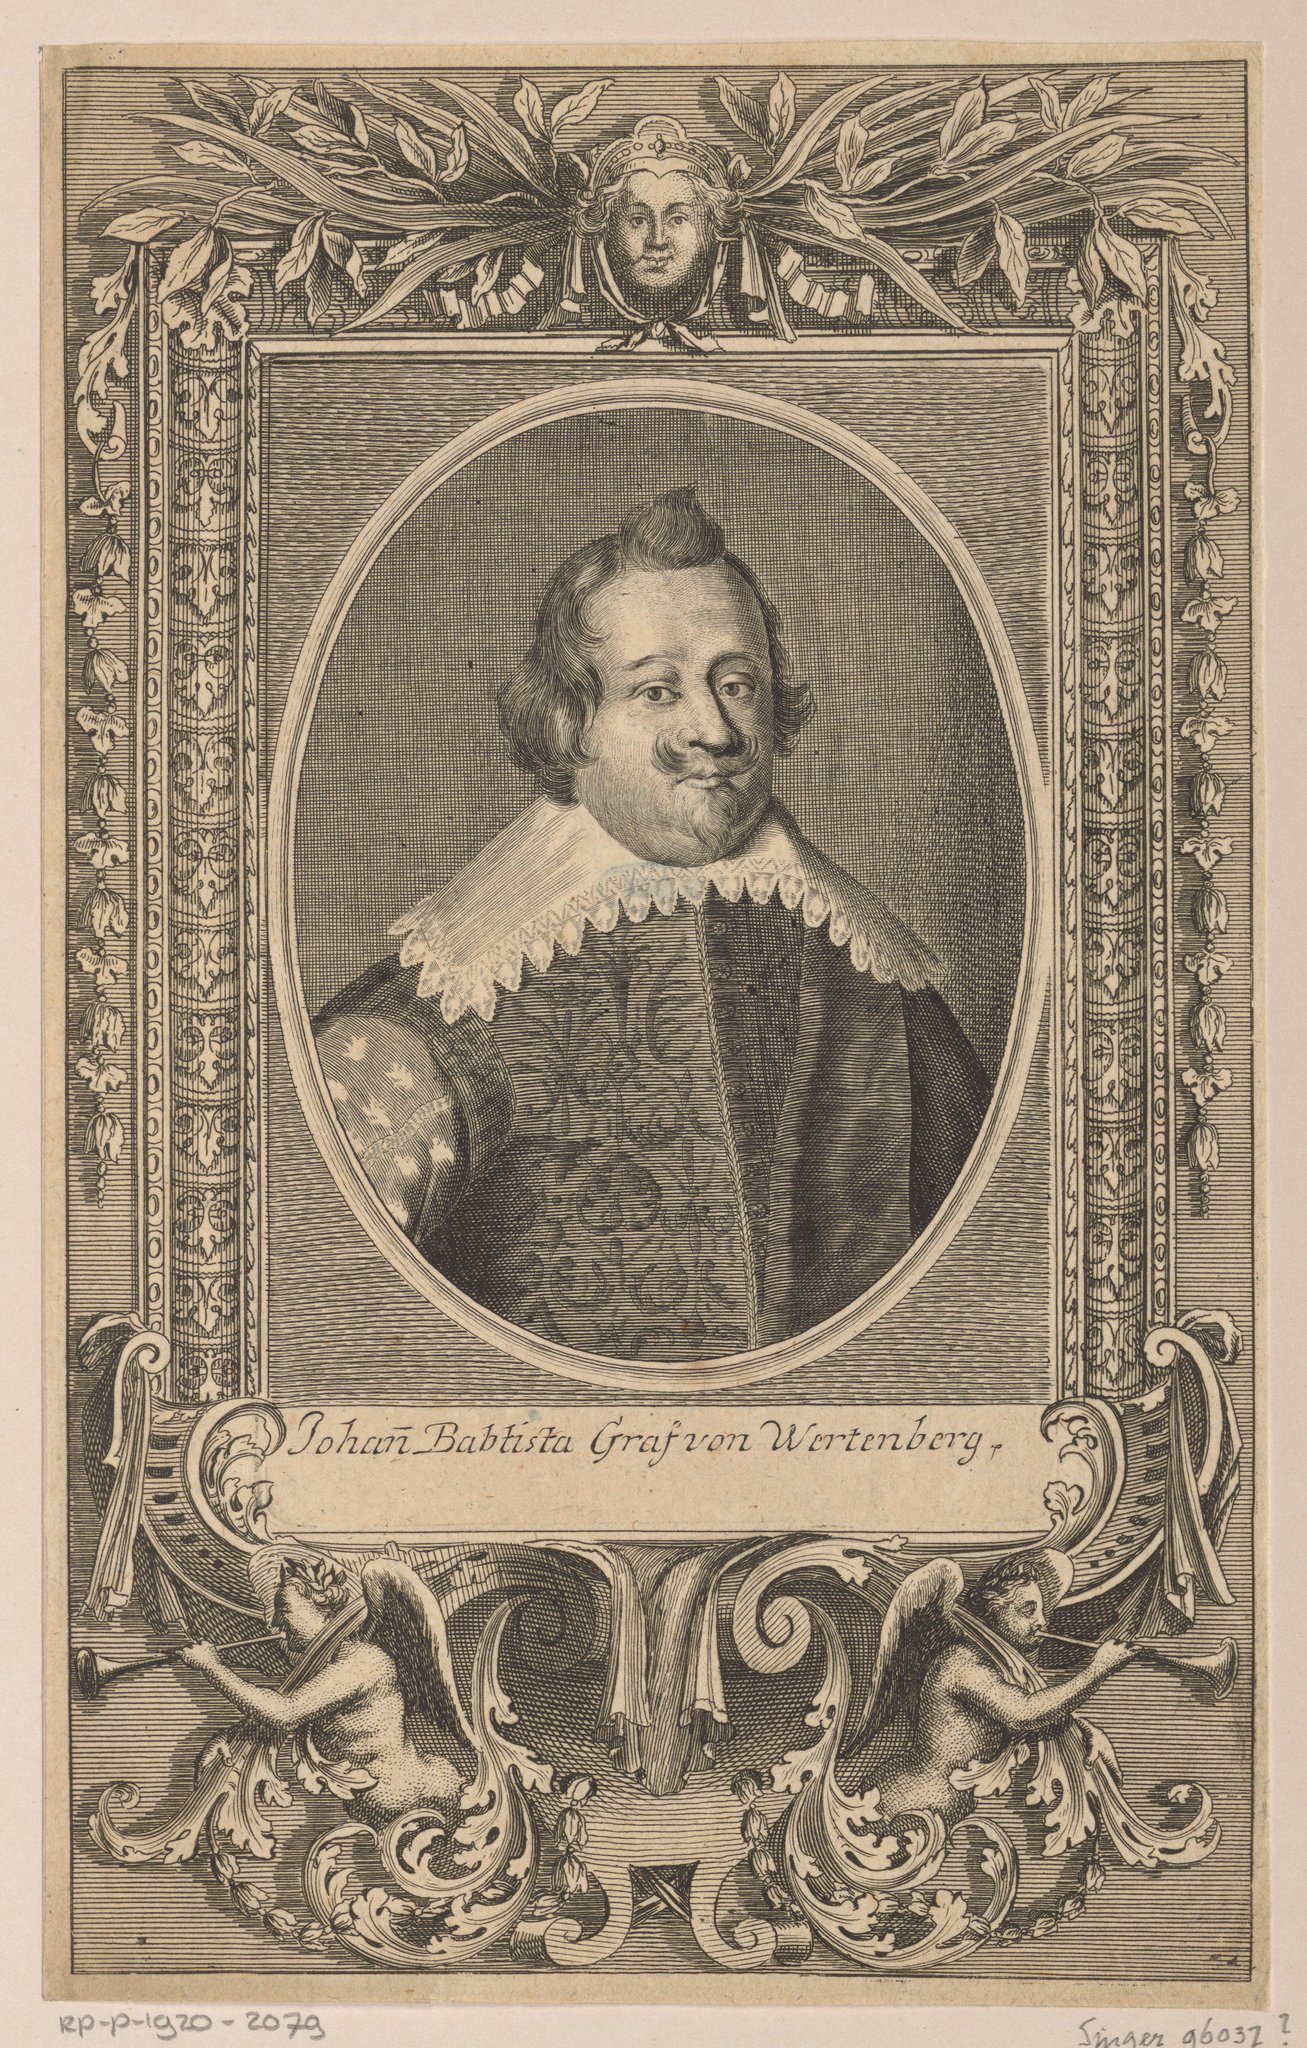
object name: print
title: Johan Babtista Graf von Wertenberg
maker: Anonymous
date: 1722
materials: paper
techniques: engraving, etching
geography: germany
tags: historical persons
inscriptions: collector's mark: Lugt 2228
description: Prent waarschijnlijk uit: Khevenhüller, Franz Christoph. Conterfet Kupfferstich (...). Leipzig: Moritz Georg Weidmann, 1722, dl. 2.